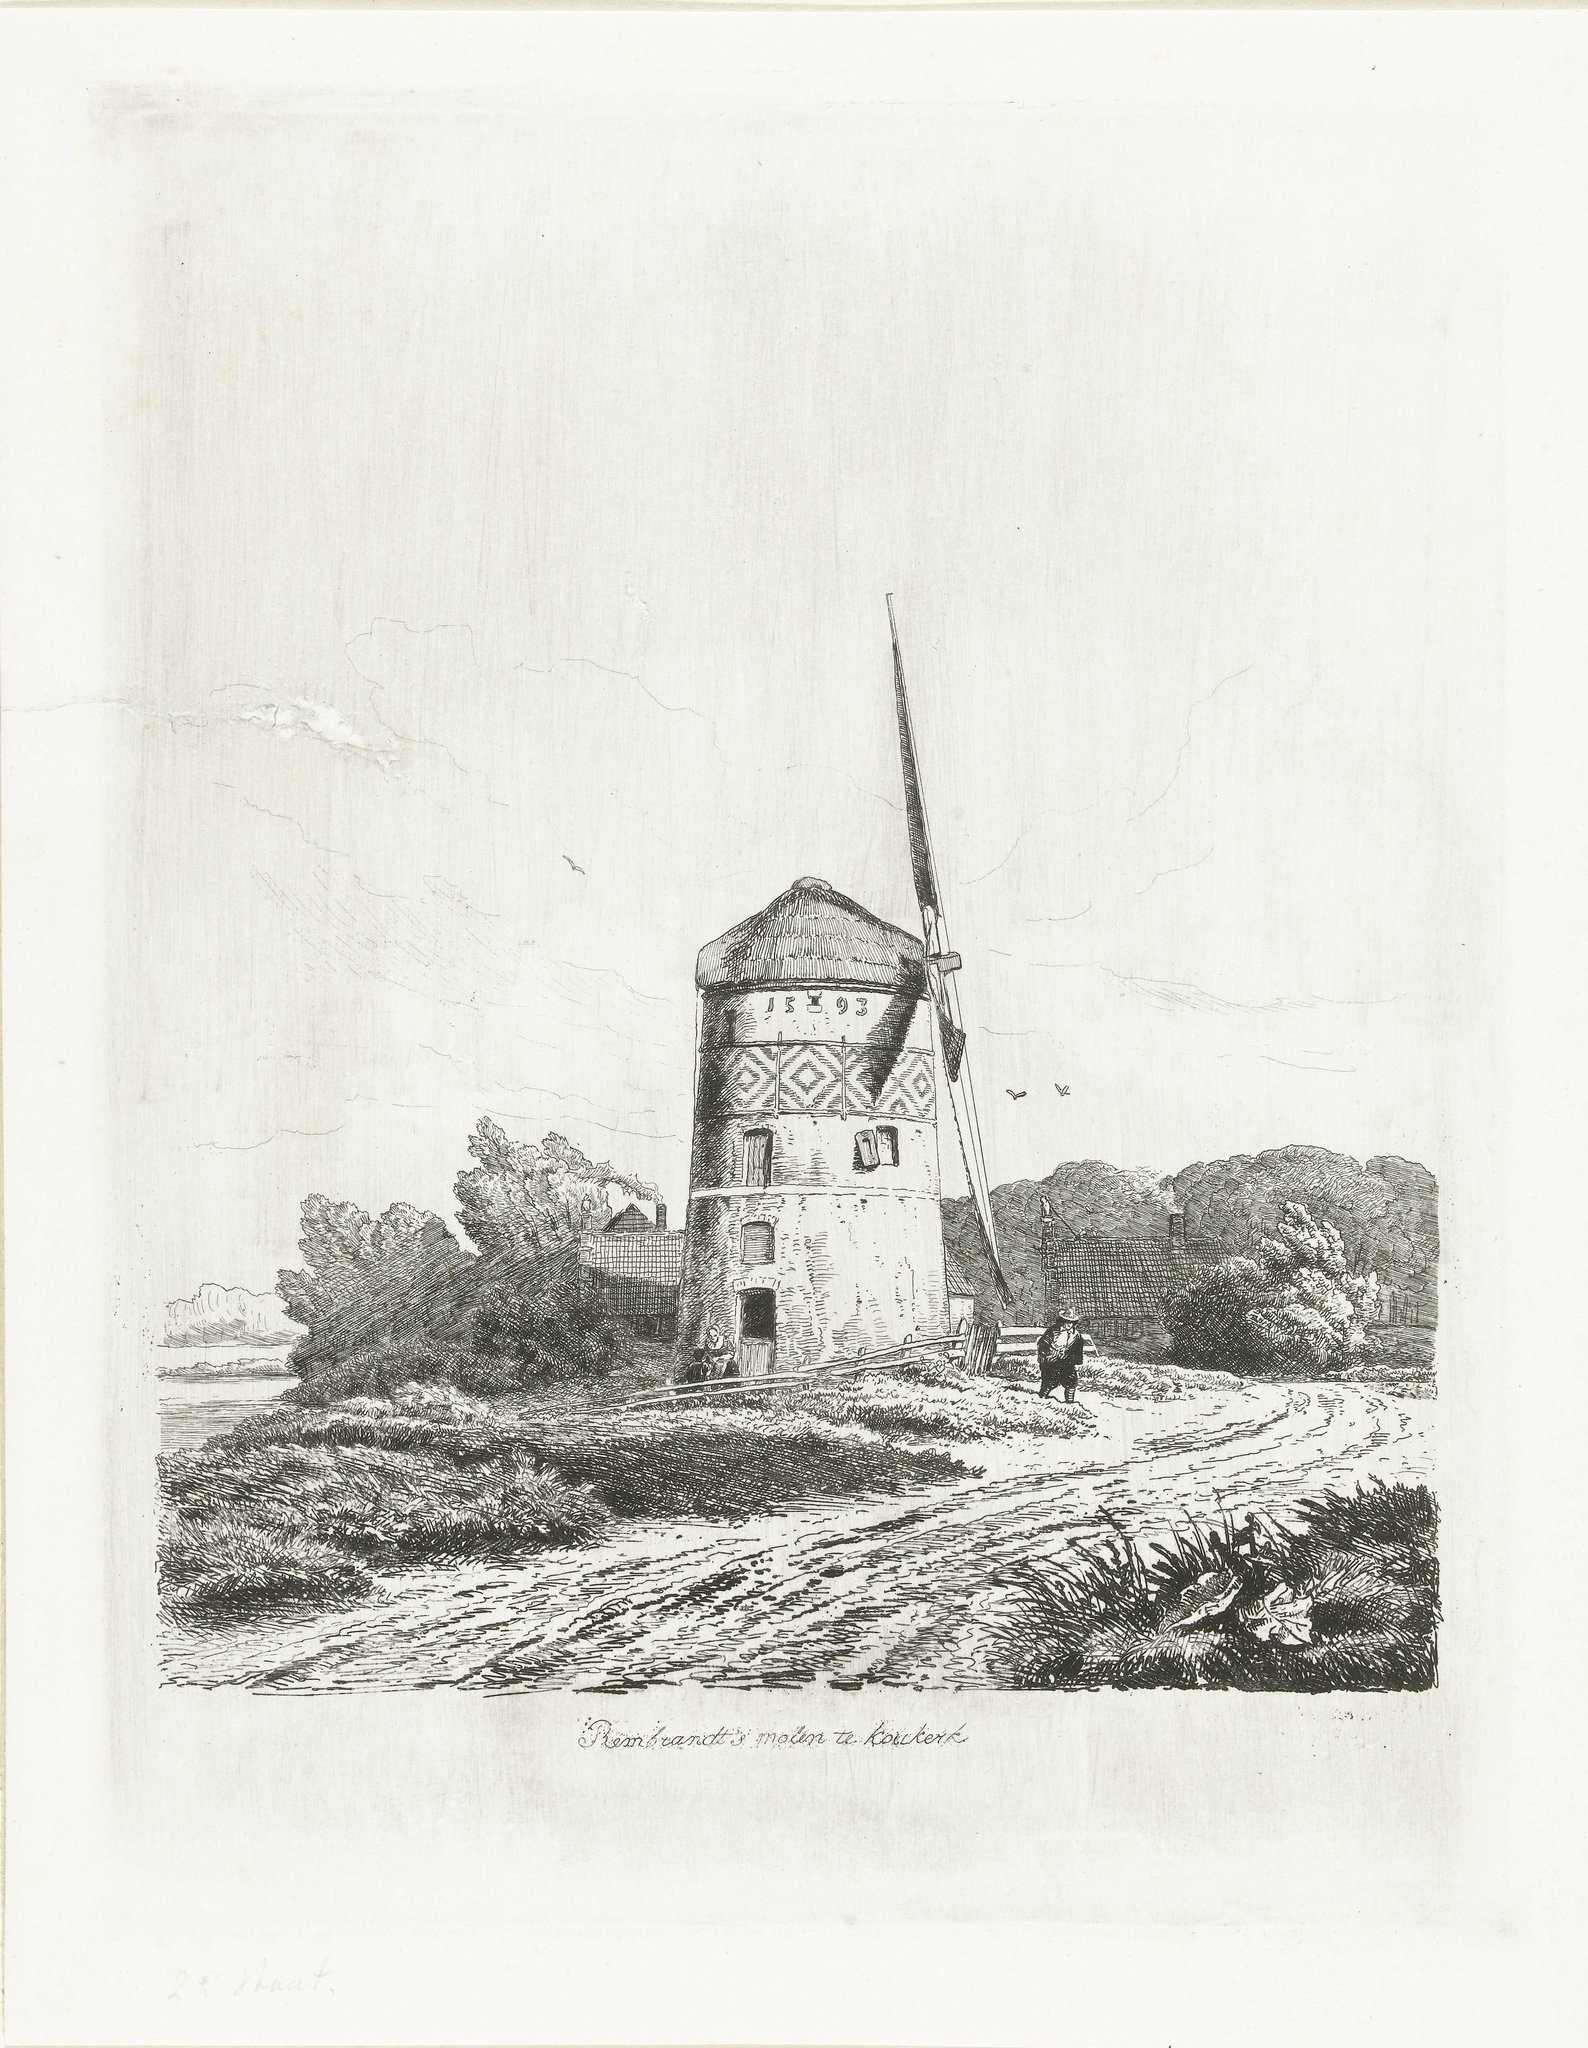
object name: print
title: Rembrandts molen te Koukerk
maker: pierre louis dubourcq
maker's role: draughtsman, painter, print maker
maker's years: 1815-1873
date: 1849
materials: paper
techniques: etching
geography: netherlands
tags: windmill in landscape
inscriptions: collector's mark: Lugt 2228